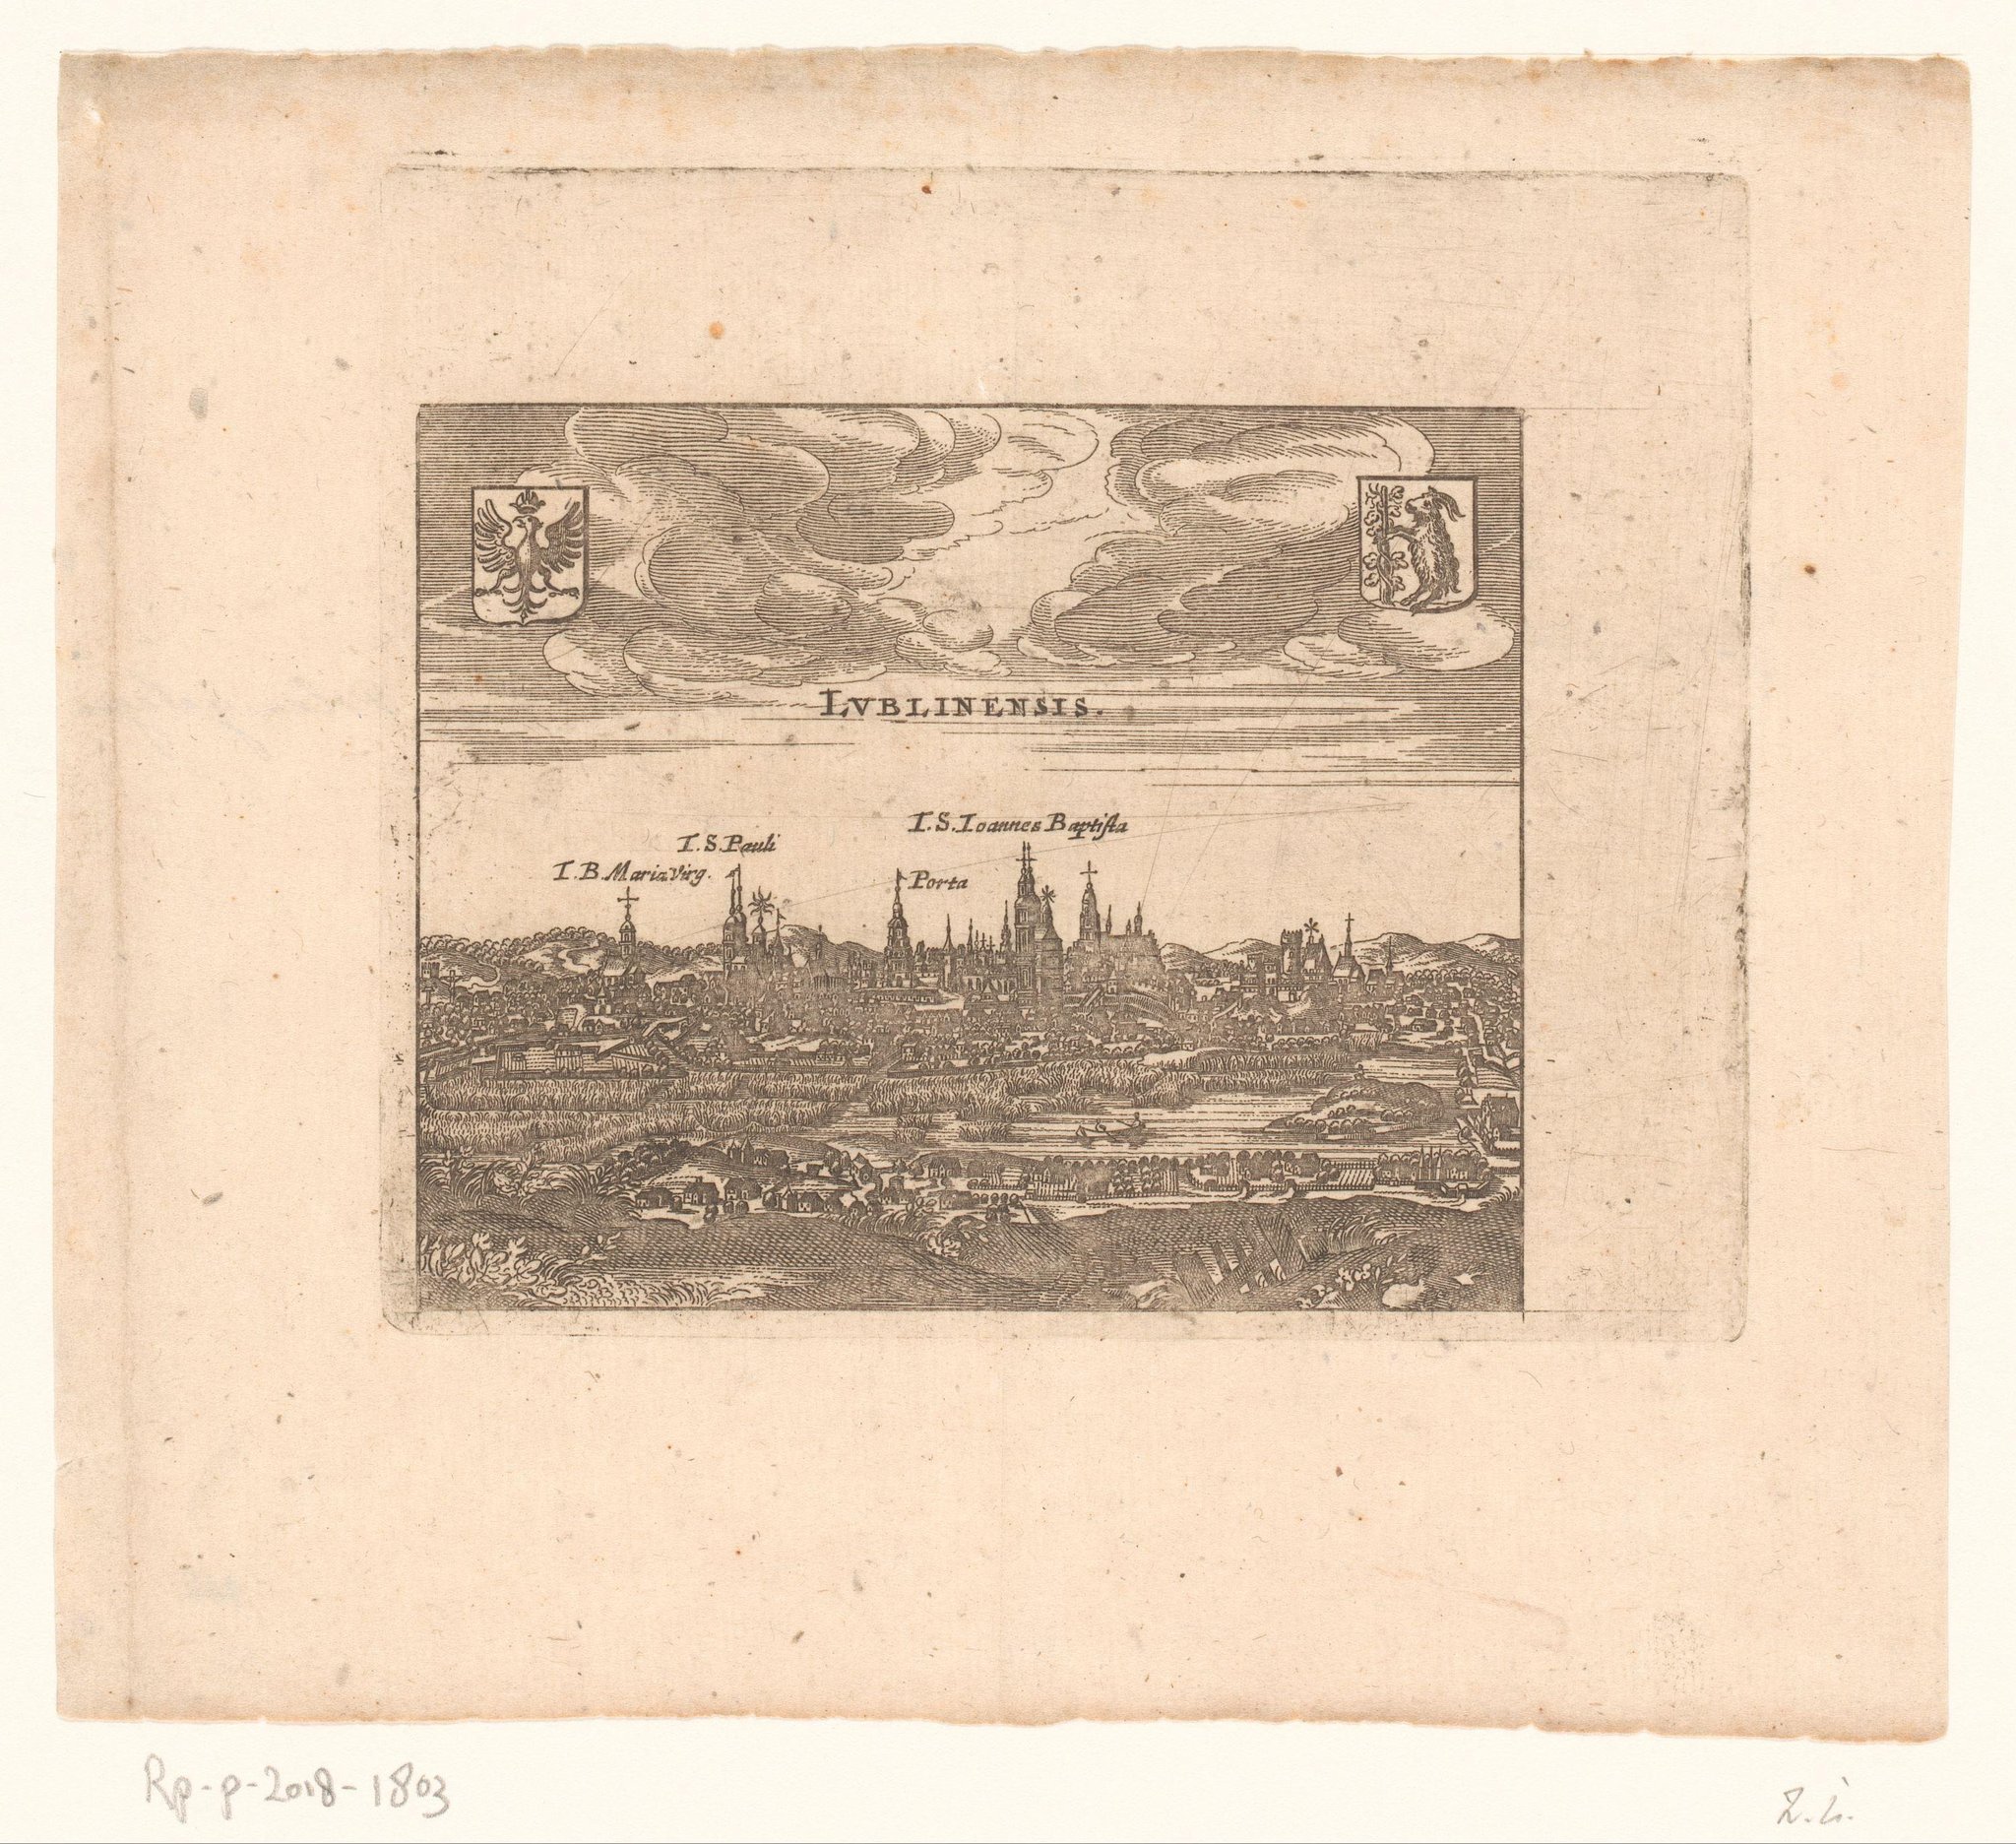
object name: print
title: Gezicht op Lublin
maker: Anonymous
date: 1650-1749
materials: paper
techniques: etching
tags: coat of arms (as symbol of the state, etc.) (+ city; municipal), coat of arms (as symbol of the state, etc.) (+ province; provincial), prospect of city, town panorama, silhouette of city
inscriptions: collector's mark: Lugt 2228